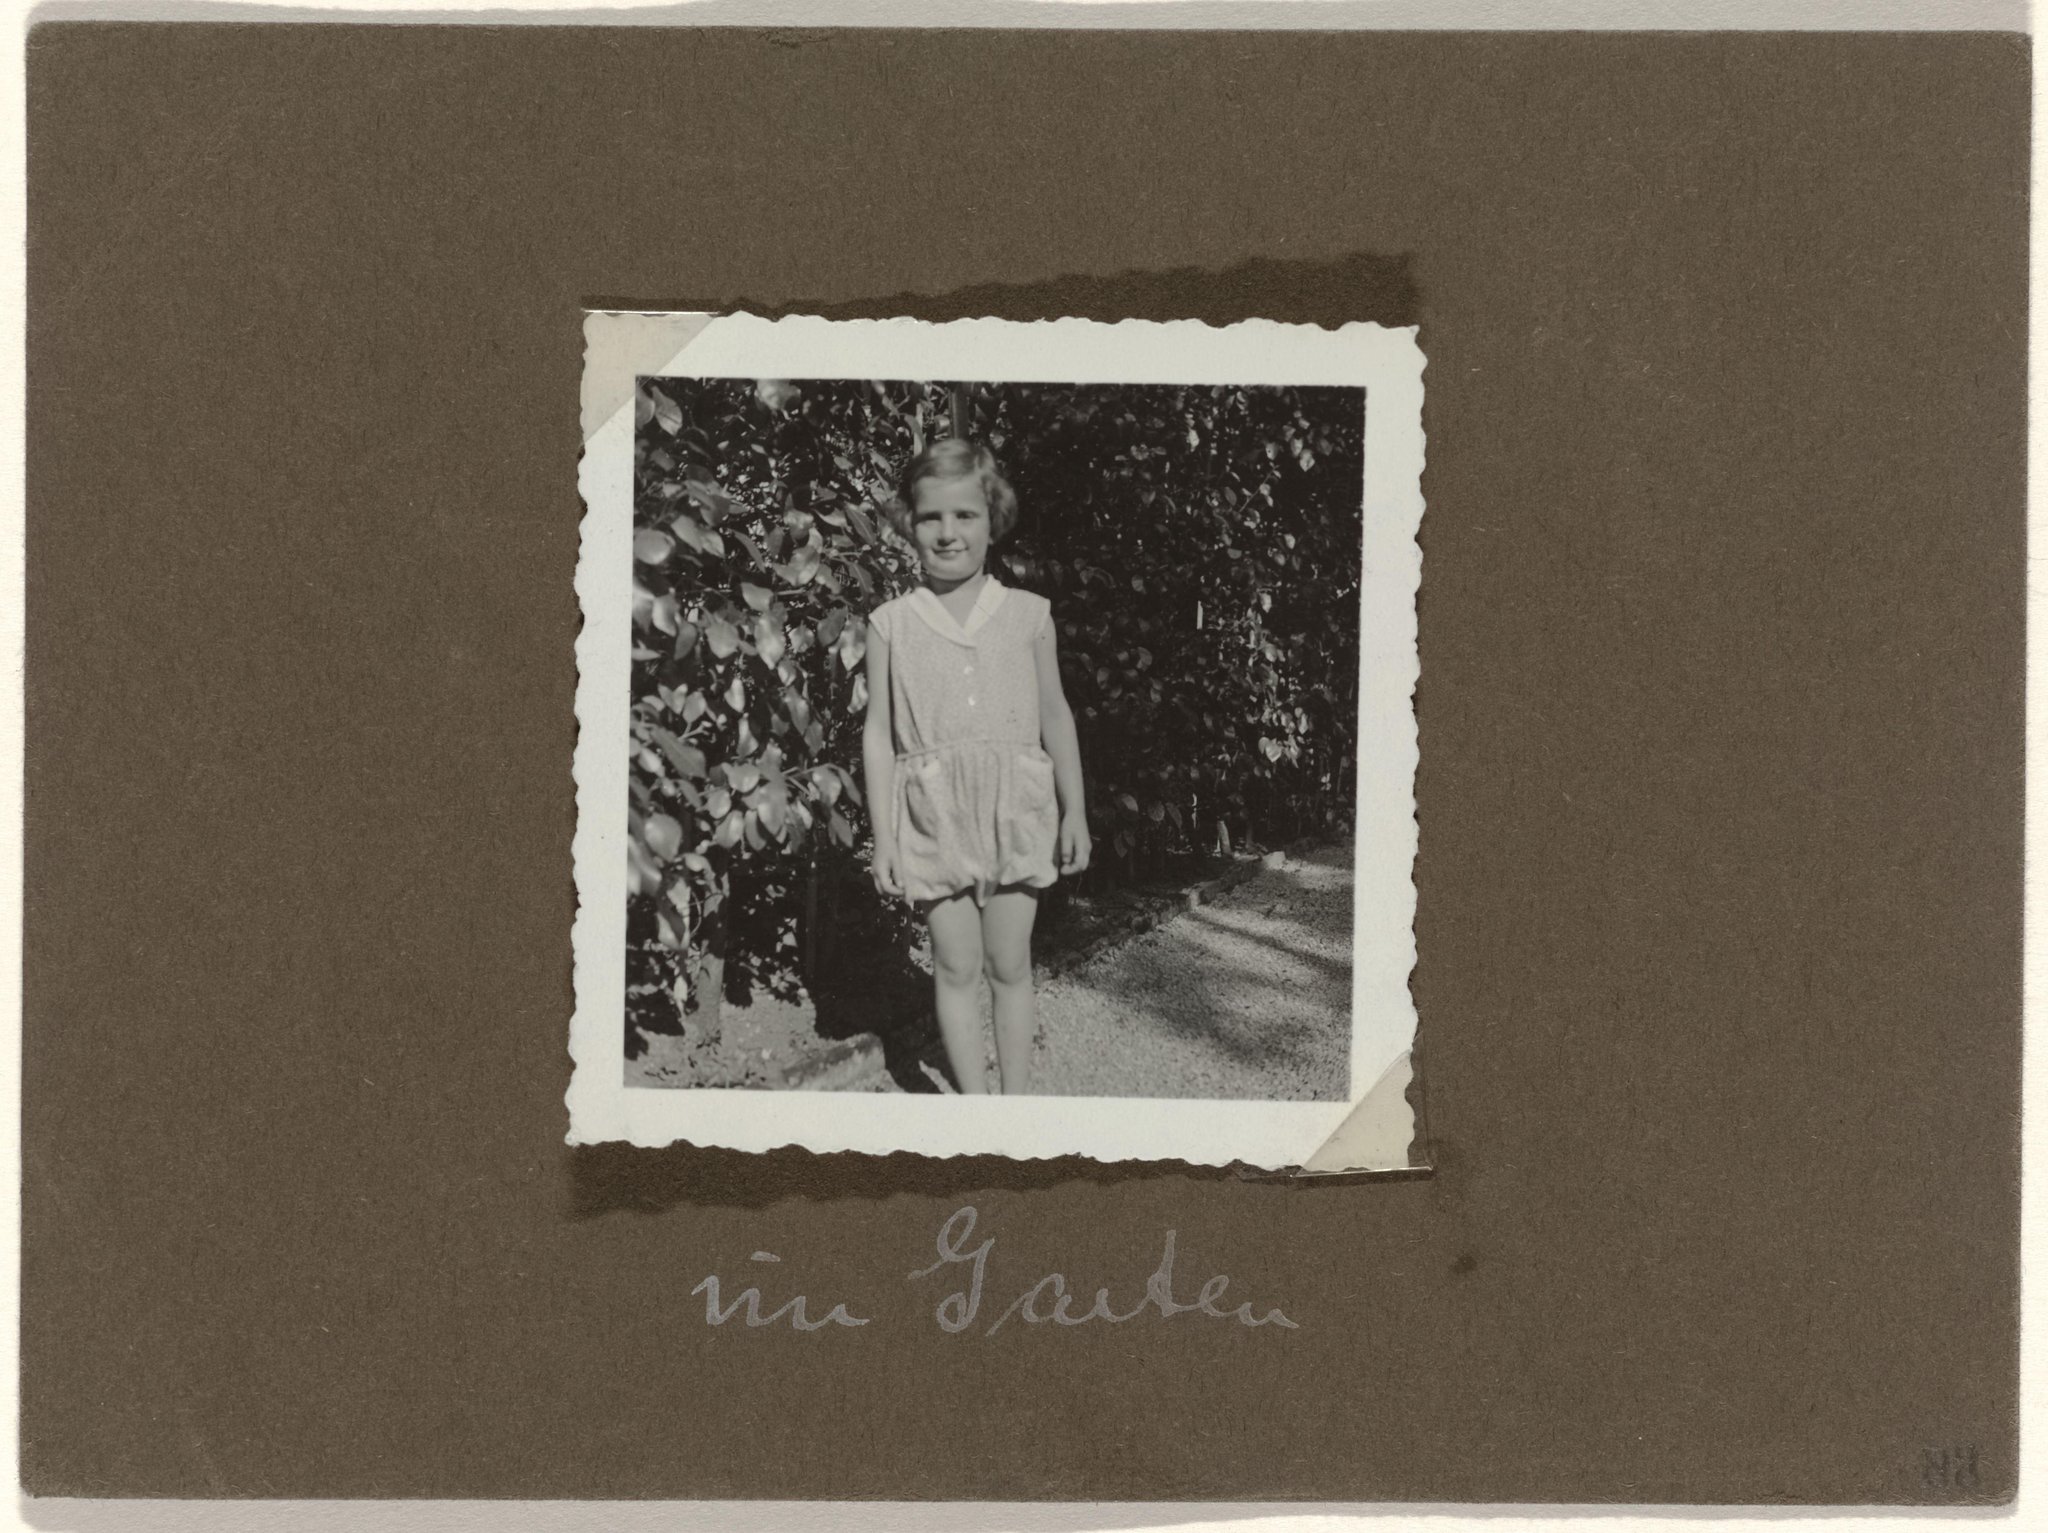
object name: photograph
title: Isabel Wachenheimer in de tuin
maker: Anonymous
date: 1905-1934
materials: photographic support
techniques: gelatin silver print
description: Dit object is onderdeel van de nalatenschap van Isabel Elon-Wachenheimer (1928-2010). Tot haar overlijden behoorde het samen met de andere objecten uit de nalatenschap tot haar privédomein van Isabel Wachenheimer. In die particuliere context zijn deze objecten tezamen en individueel aandenkens - aan de jeugd, ouders en familie van Isabel Wachenheimer vóór en tijdens de Shoah en aan haar leven na de Tweede Wereldoorlog. Isabel Wachenheimer, die van juni 1943 tot mei 1945 gevangen zat in Kamp Westerbork, Theresienstadt, Auschwitz, Lenzing a/d Oberdonau (een buitenkamp van Mauthausen), overleefde de Shoah. Haar ouders – Eugène Wachenheimer en Else Wachenheimer-Moos - werden op 14 oktober 1944 in Auschwitz-Birkenau vermoord.